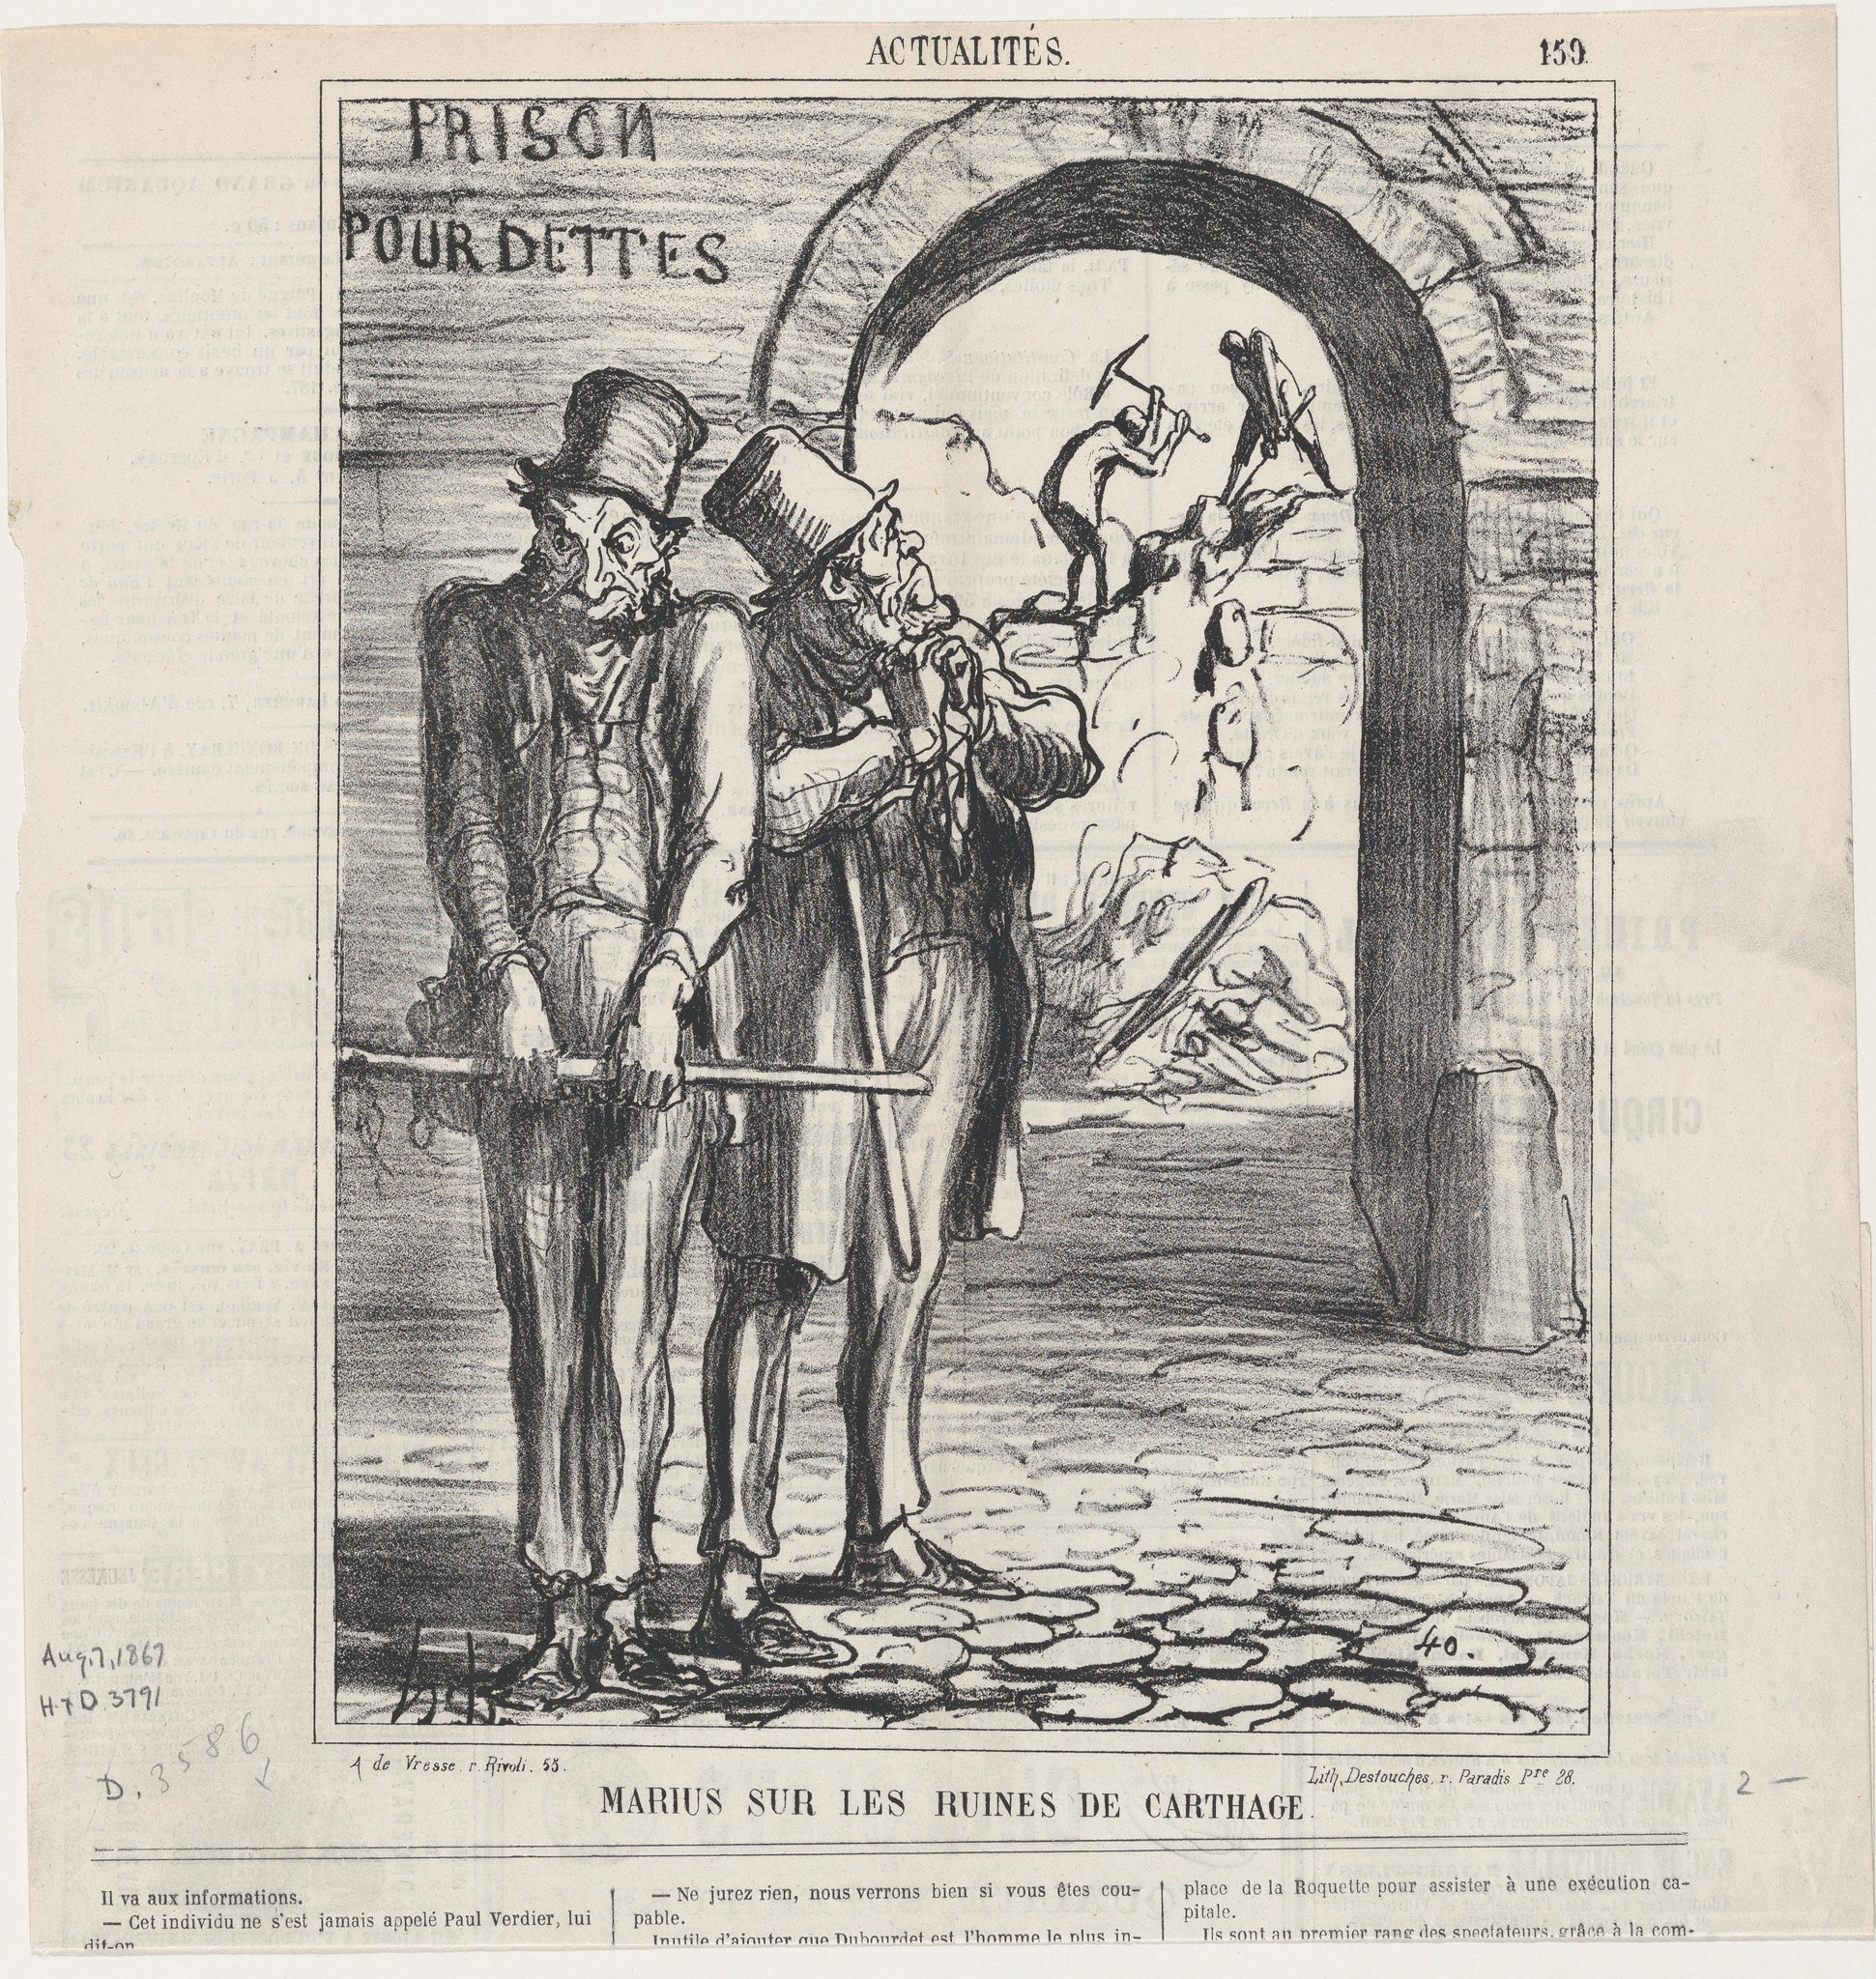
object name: print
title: Marius in the ruins of Carthage, from 'News of the day,' published in Le Charivari, August 7, 1867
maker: honoré daumier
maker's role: artist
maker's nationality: french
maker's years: 1808-1879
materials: paper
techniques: lithograph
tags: satire,men